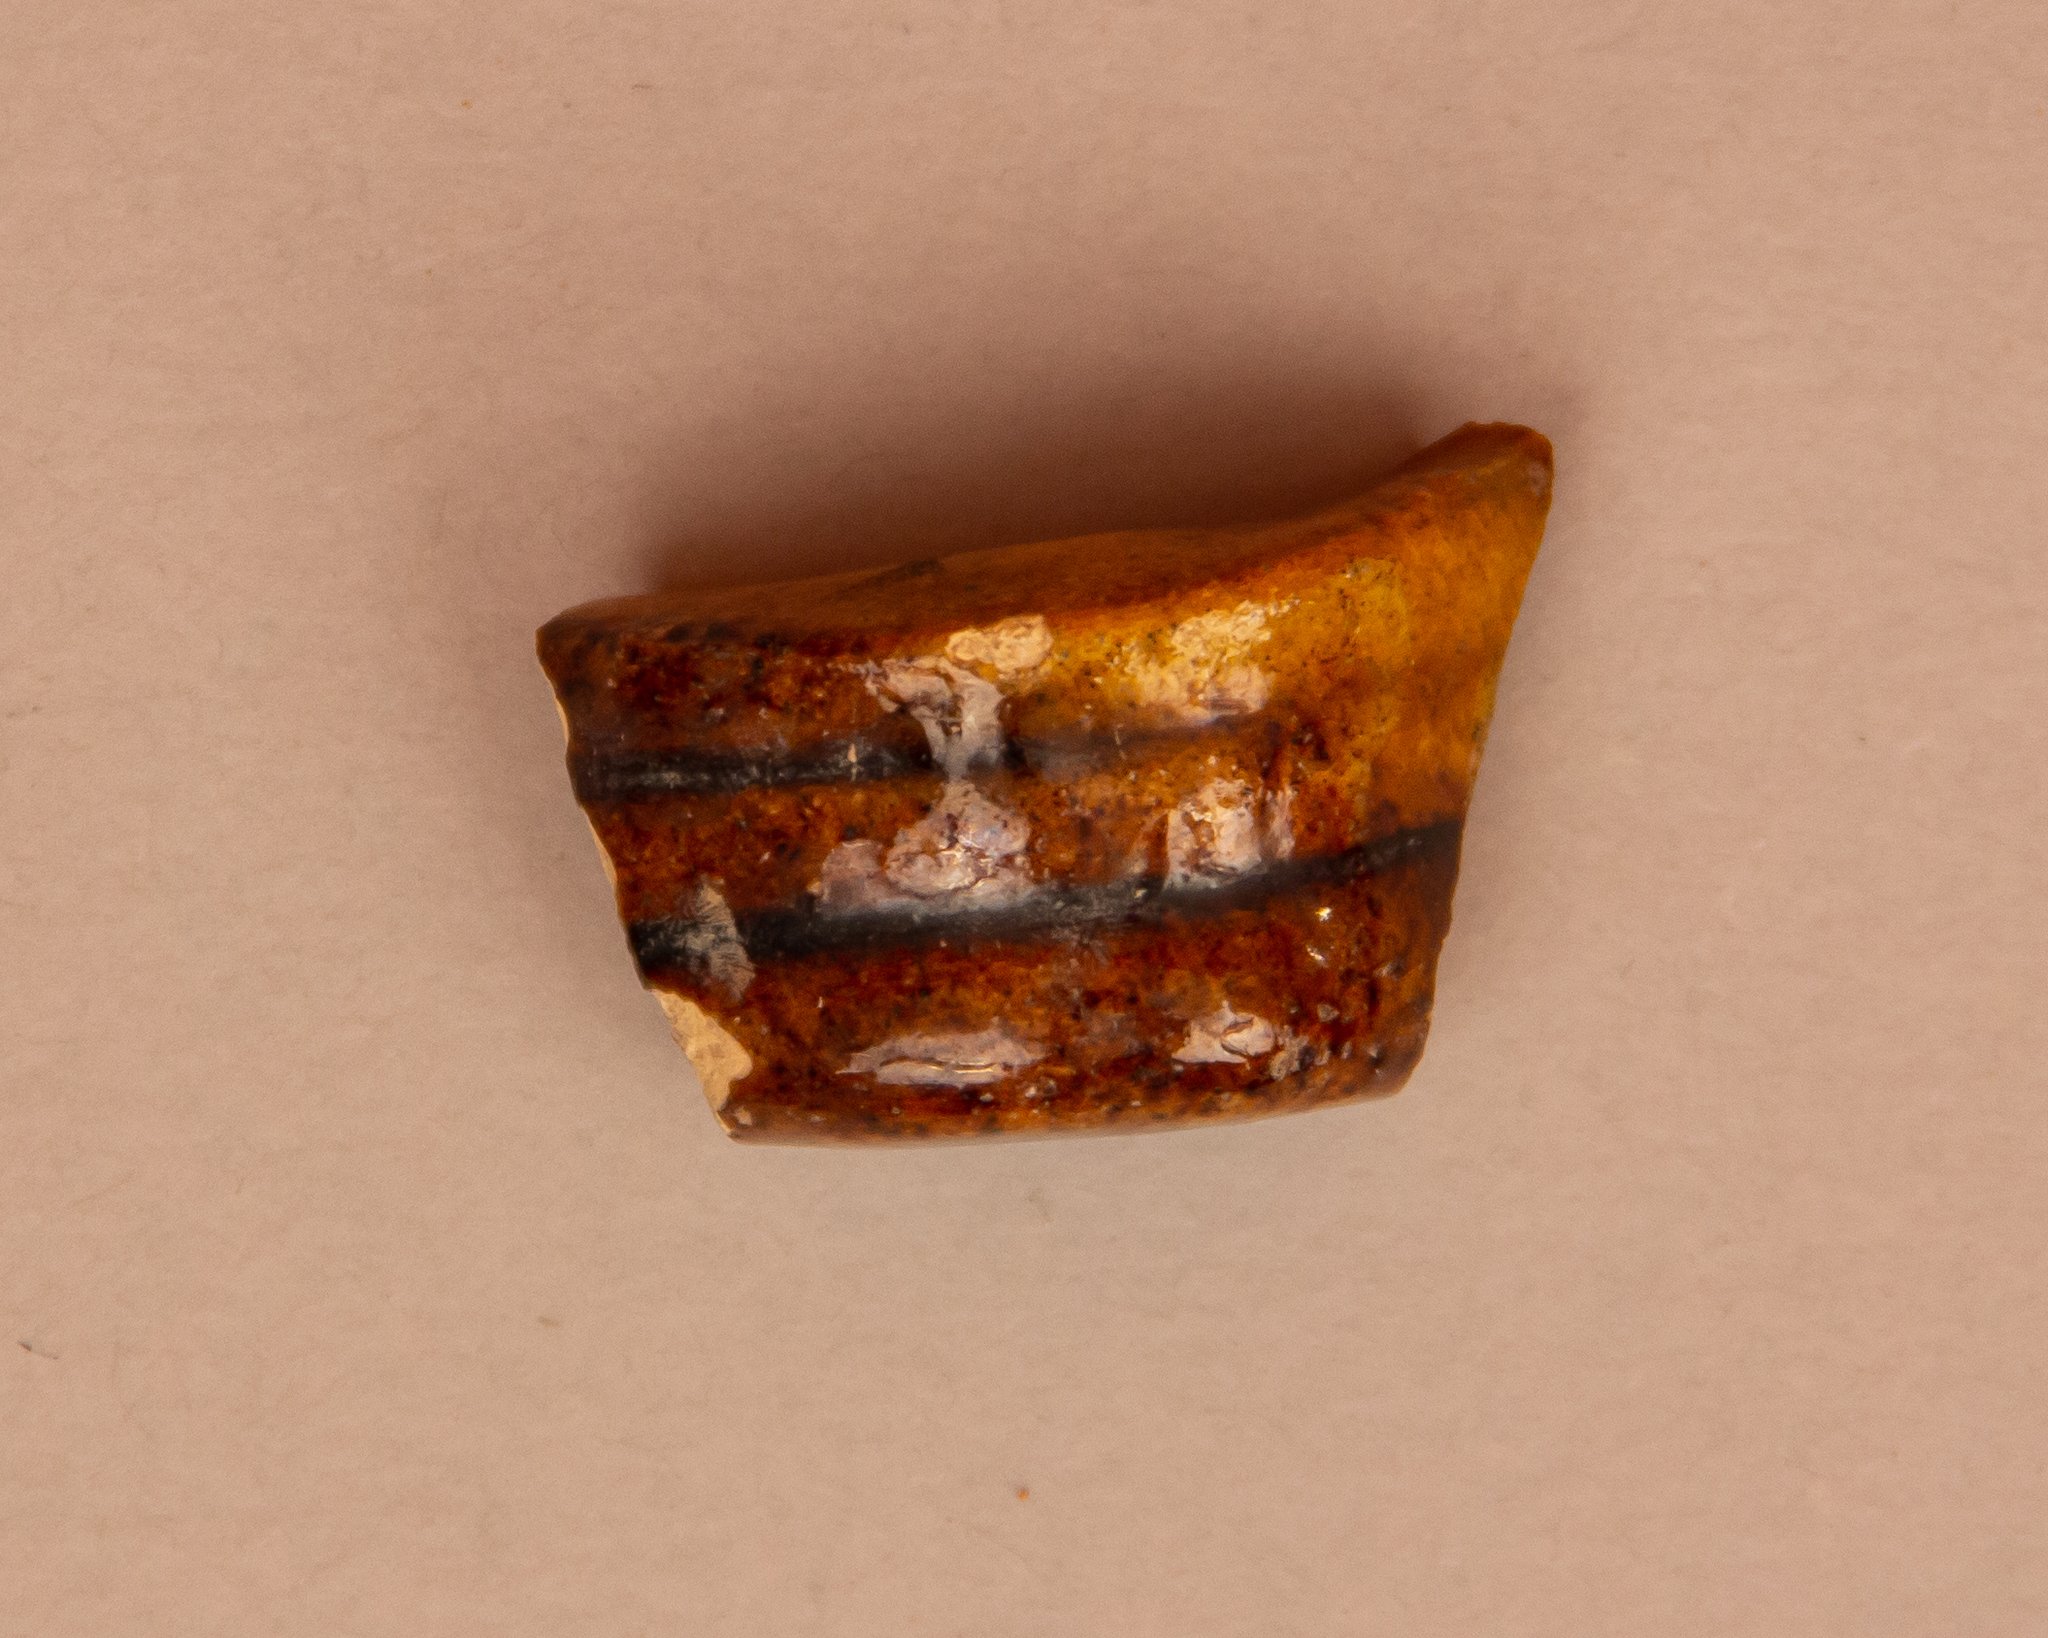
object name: fragment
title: Ceramic Fragments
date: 801-900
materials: earthenware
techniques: glazing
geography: iraq